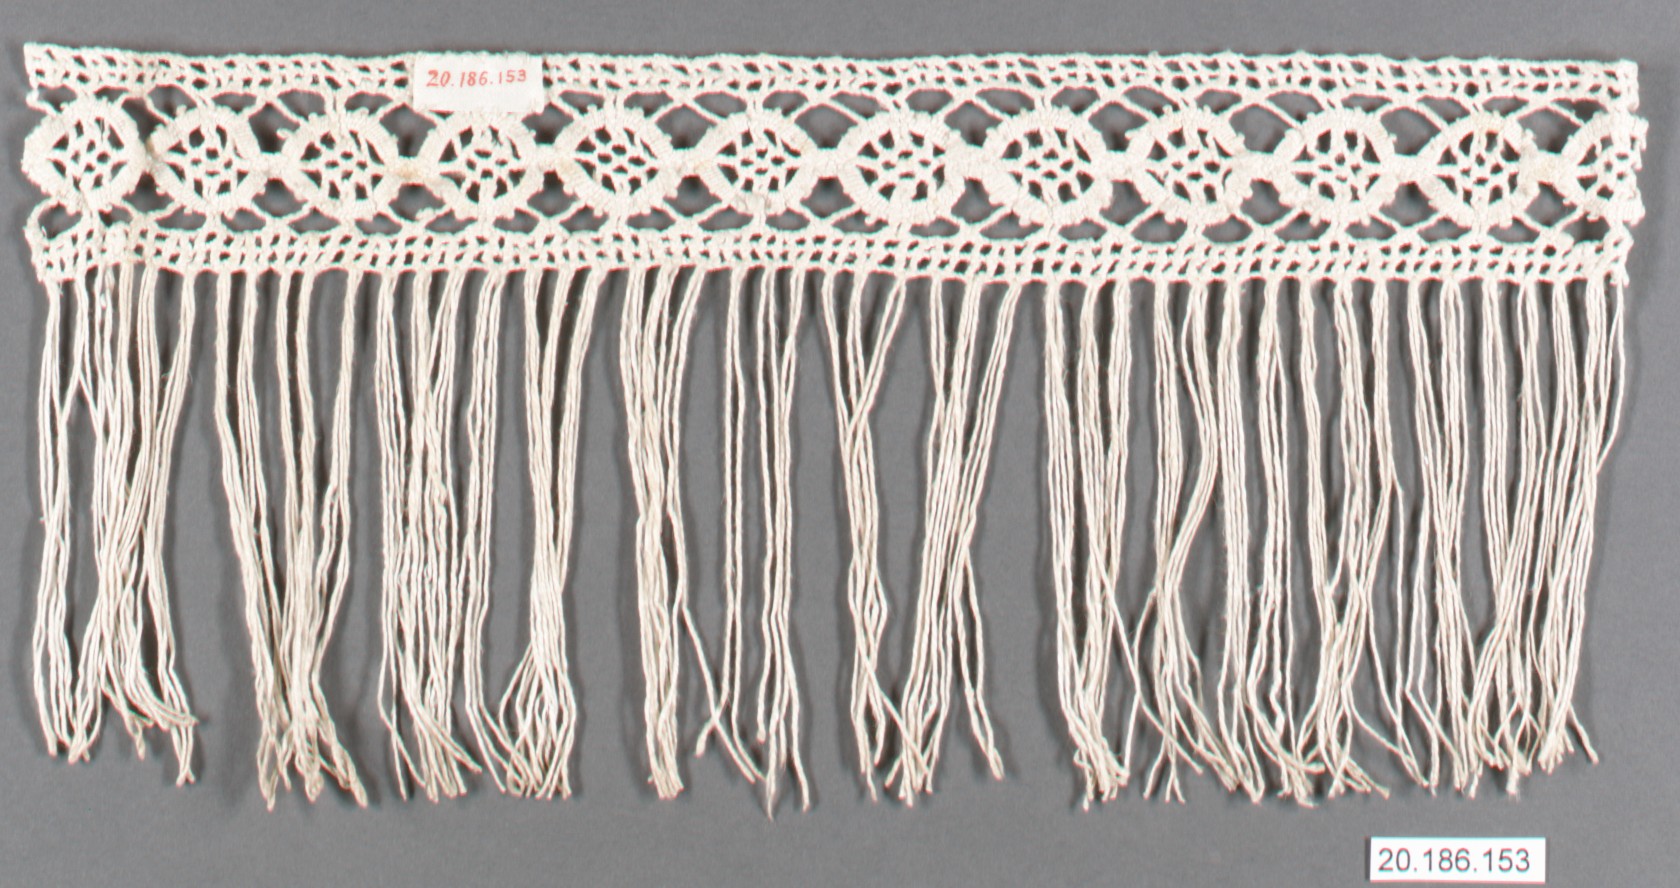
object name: edging with fringe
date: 1501-1600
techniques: lace